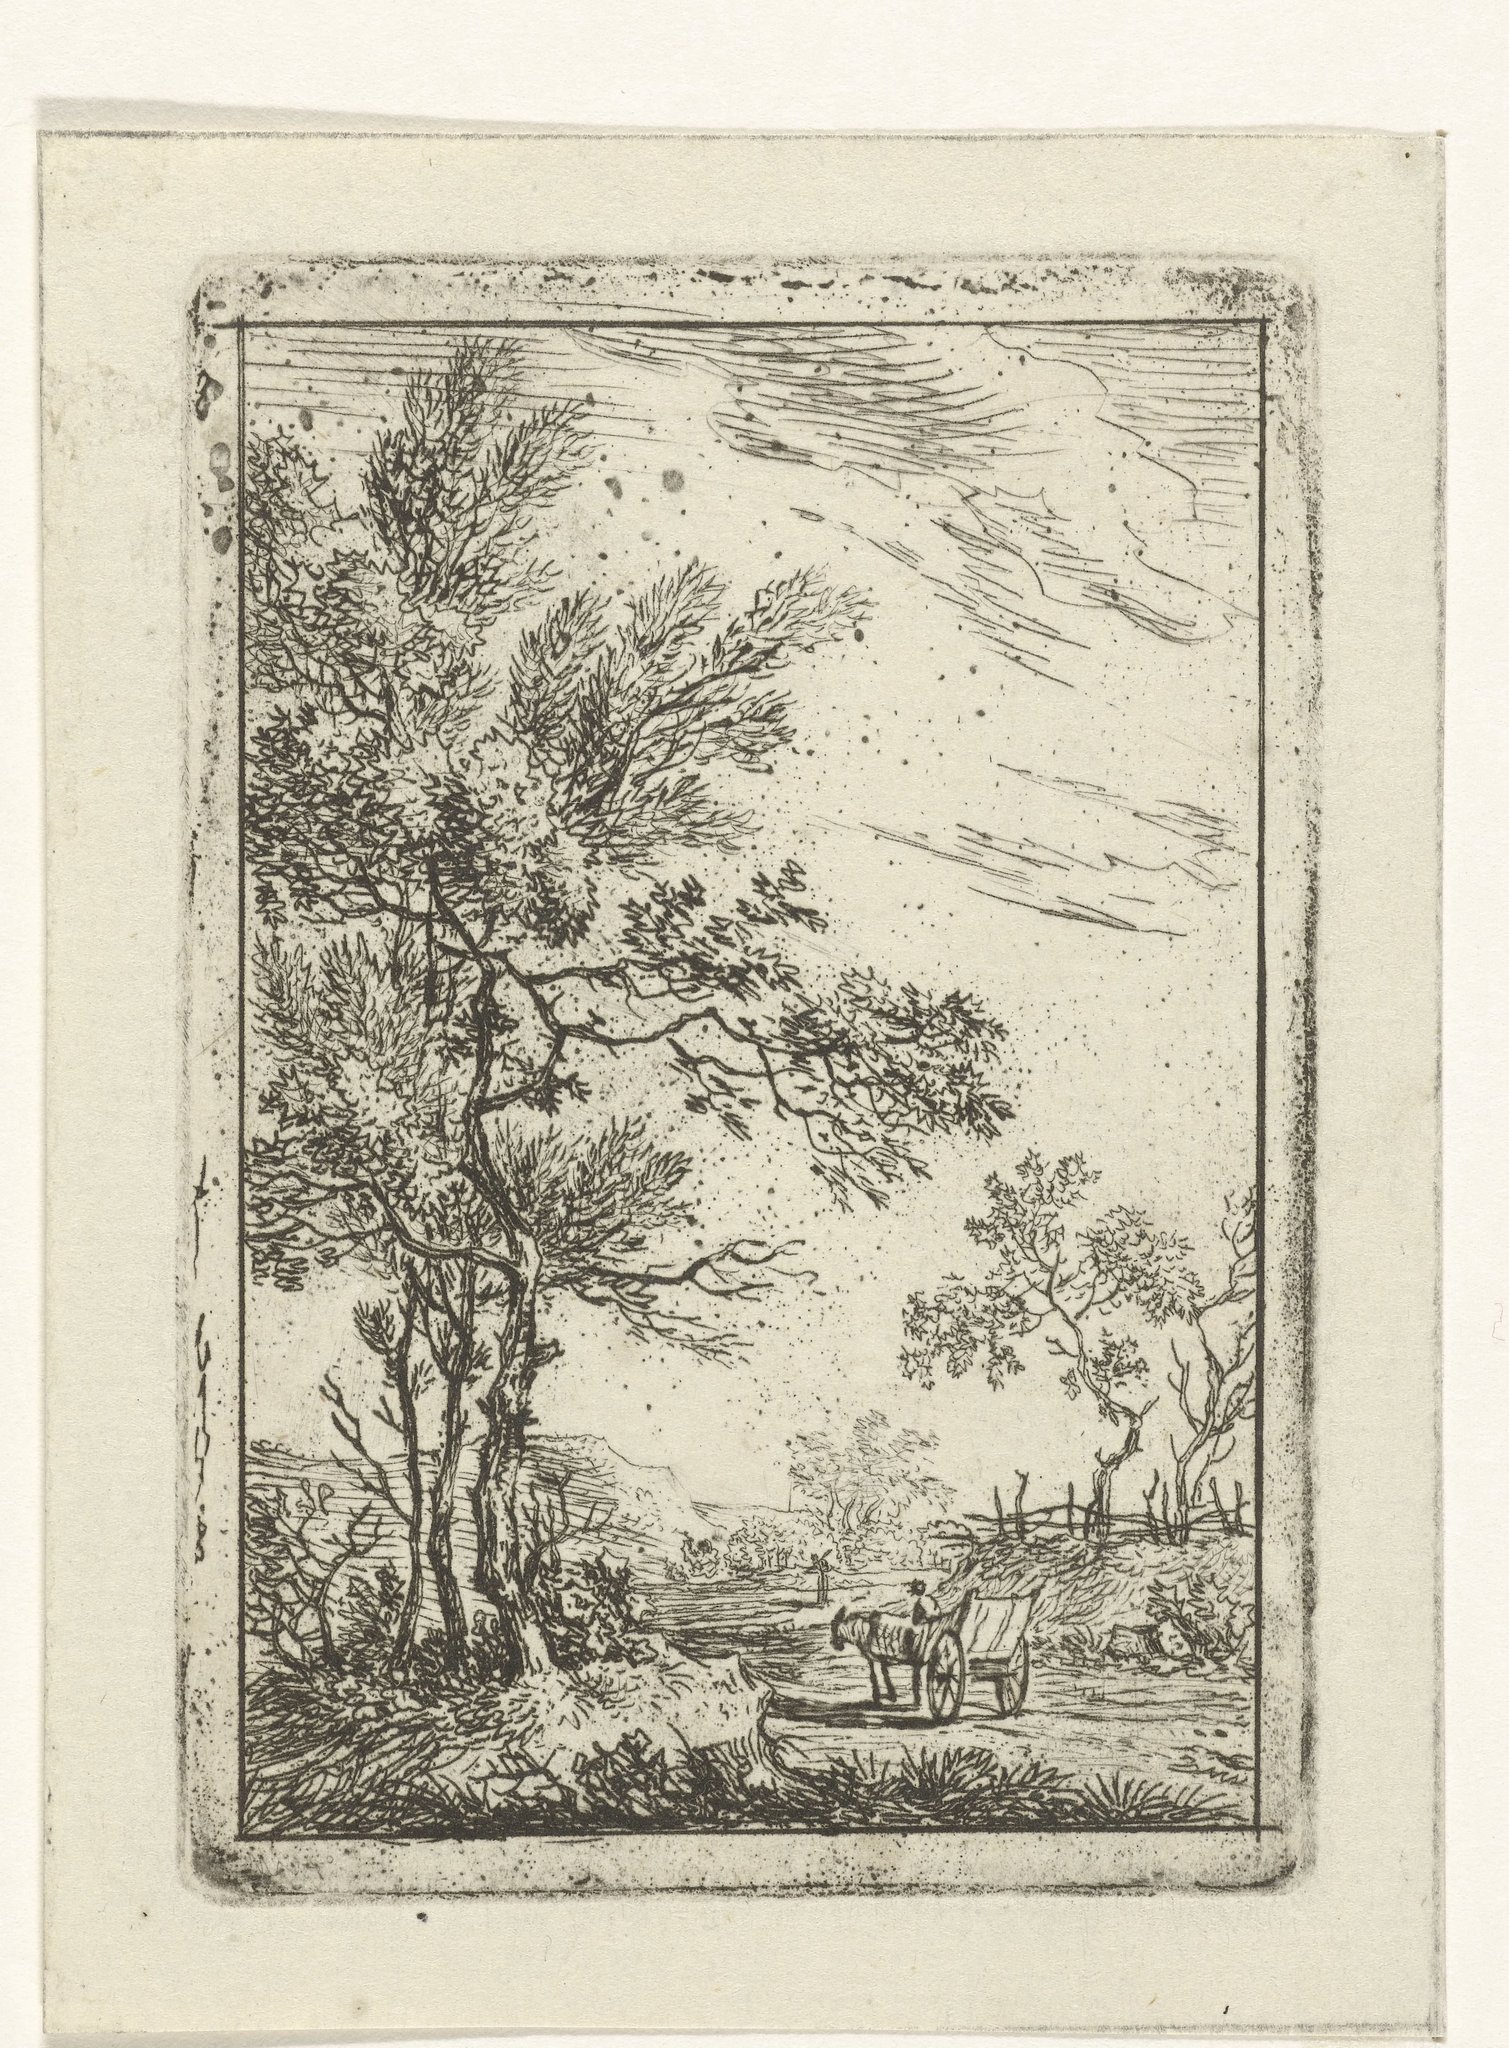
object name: print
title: Landschap met hoge boompartij en paard en wagen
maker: hermanus fock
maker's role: conservator, draughtsman, painter, print maker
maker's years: 1766-1822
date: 1781-1822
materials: paper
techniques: etching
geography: amsterdam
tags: two-wheeled vehicle drawn by one animal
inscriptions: collector's mark: Lugt 2228